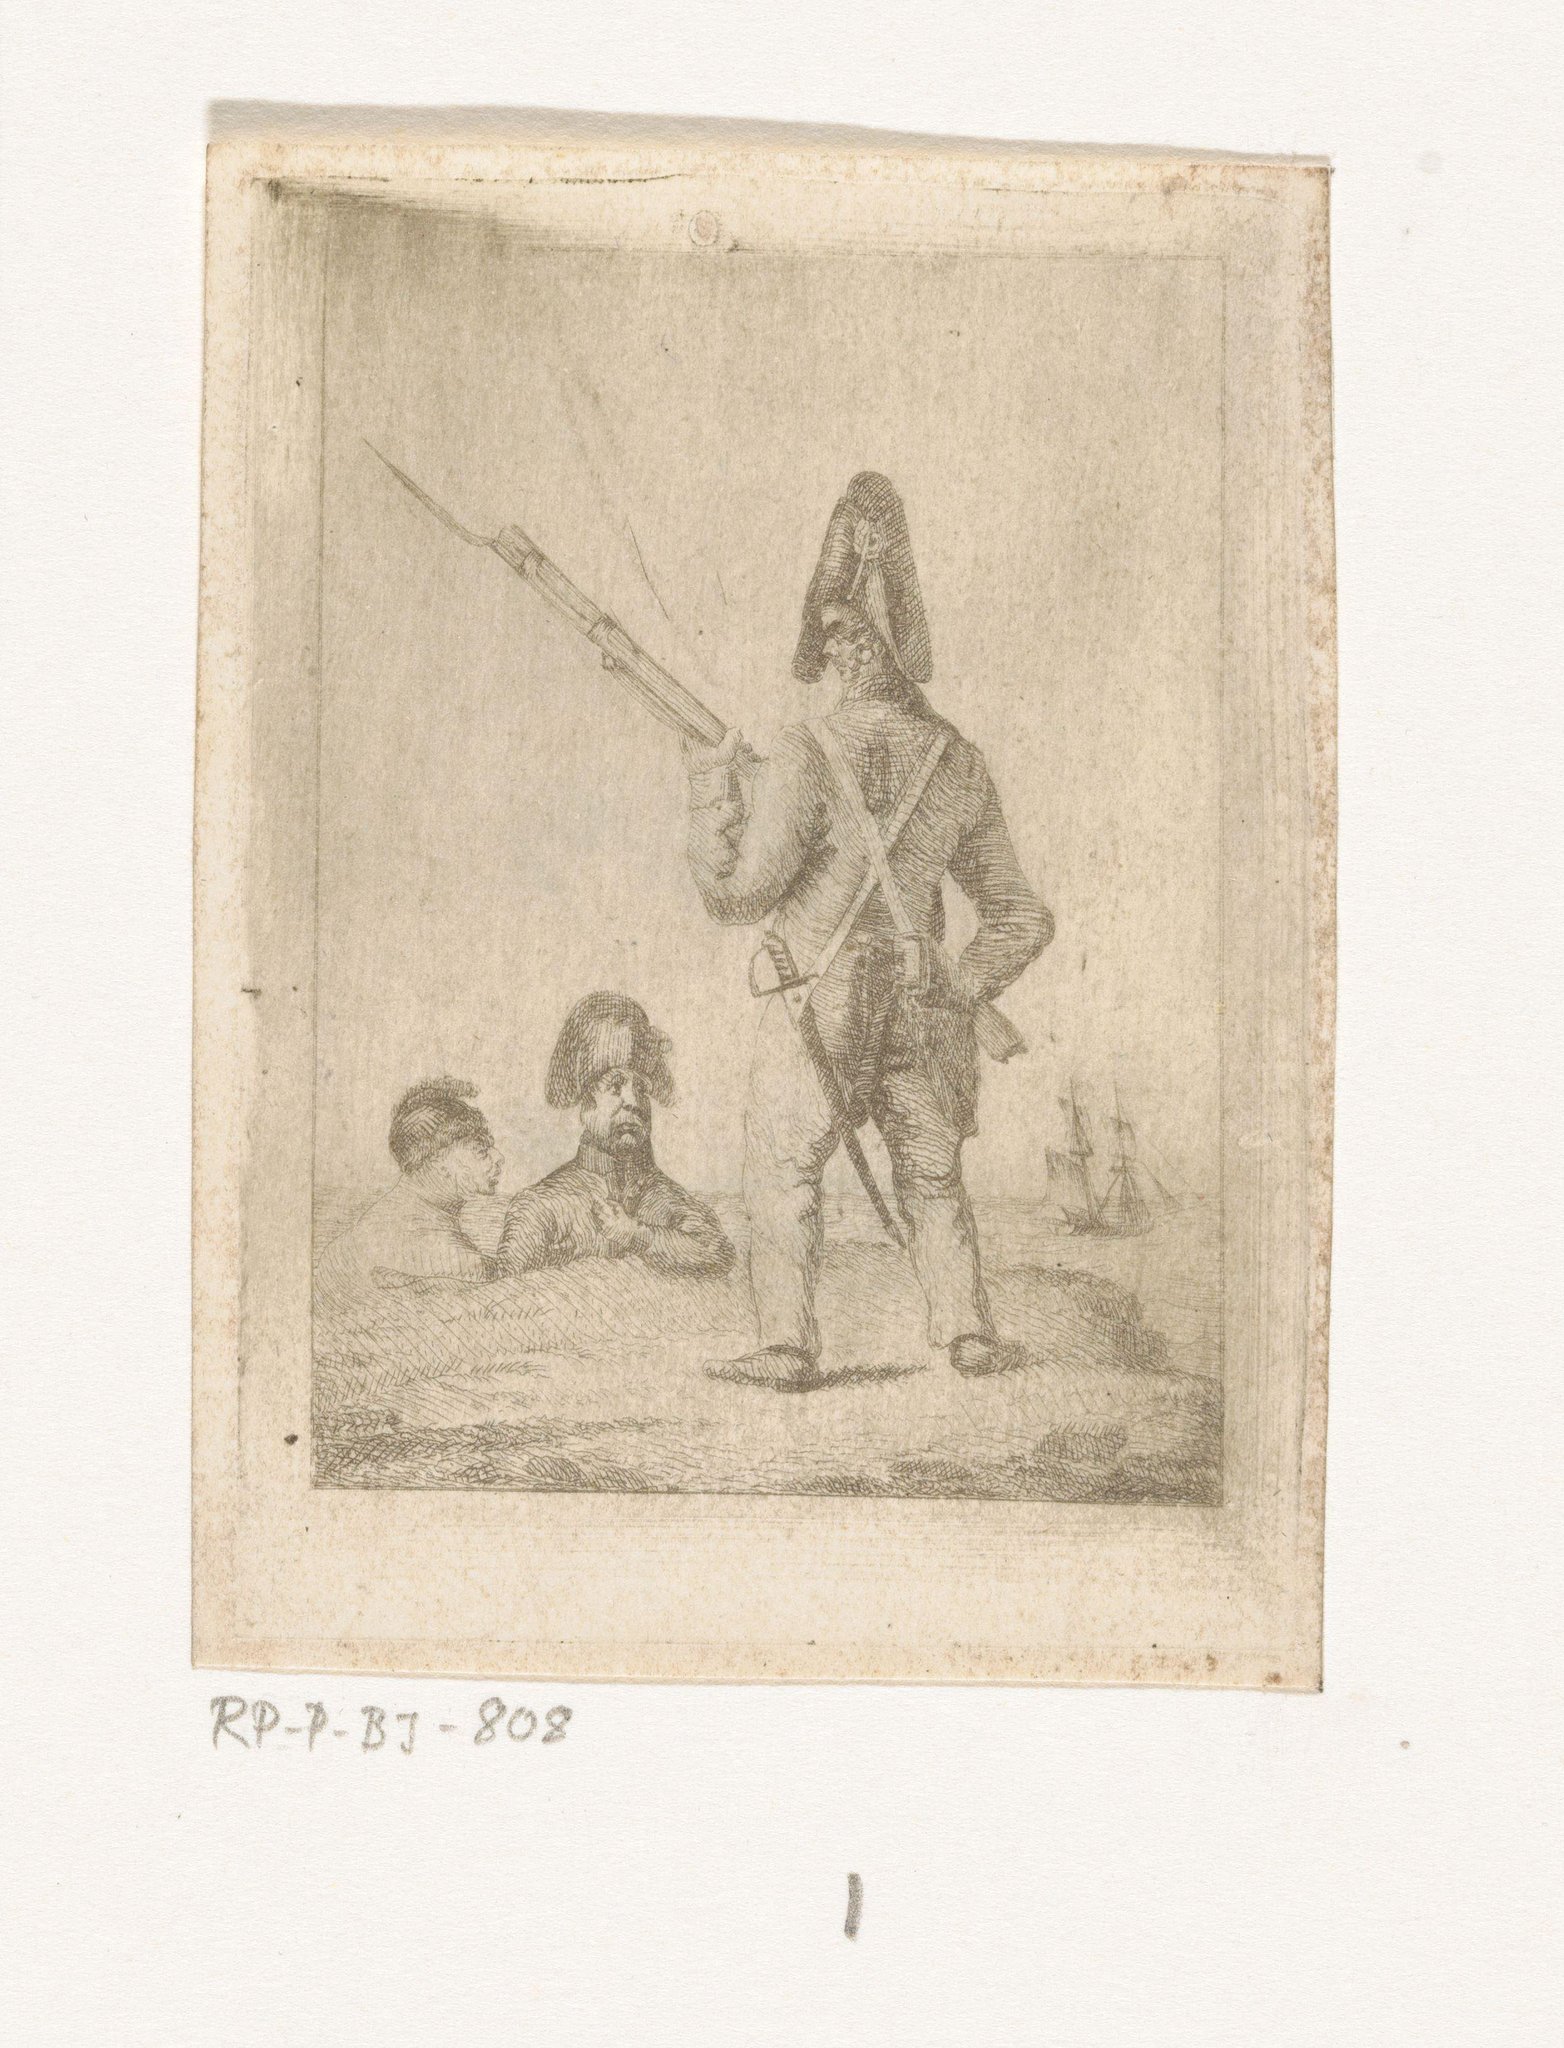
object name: print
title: Studieblad met een soldaat aan het strand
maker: joannes bemme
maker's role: print maker, printer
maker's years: 1775-1841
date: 1800-1841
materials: paper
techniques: drypoint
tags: the soldier; the soldier's life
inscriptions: collector's mark: Lugt 2228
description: Studieblad met een soldaat aan het strand, op zijn rug gezien. Op de grond twee hoofden van soldaten. In het verschiet een zeilschip.